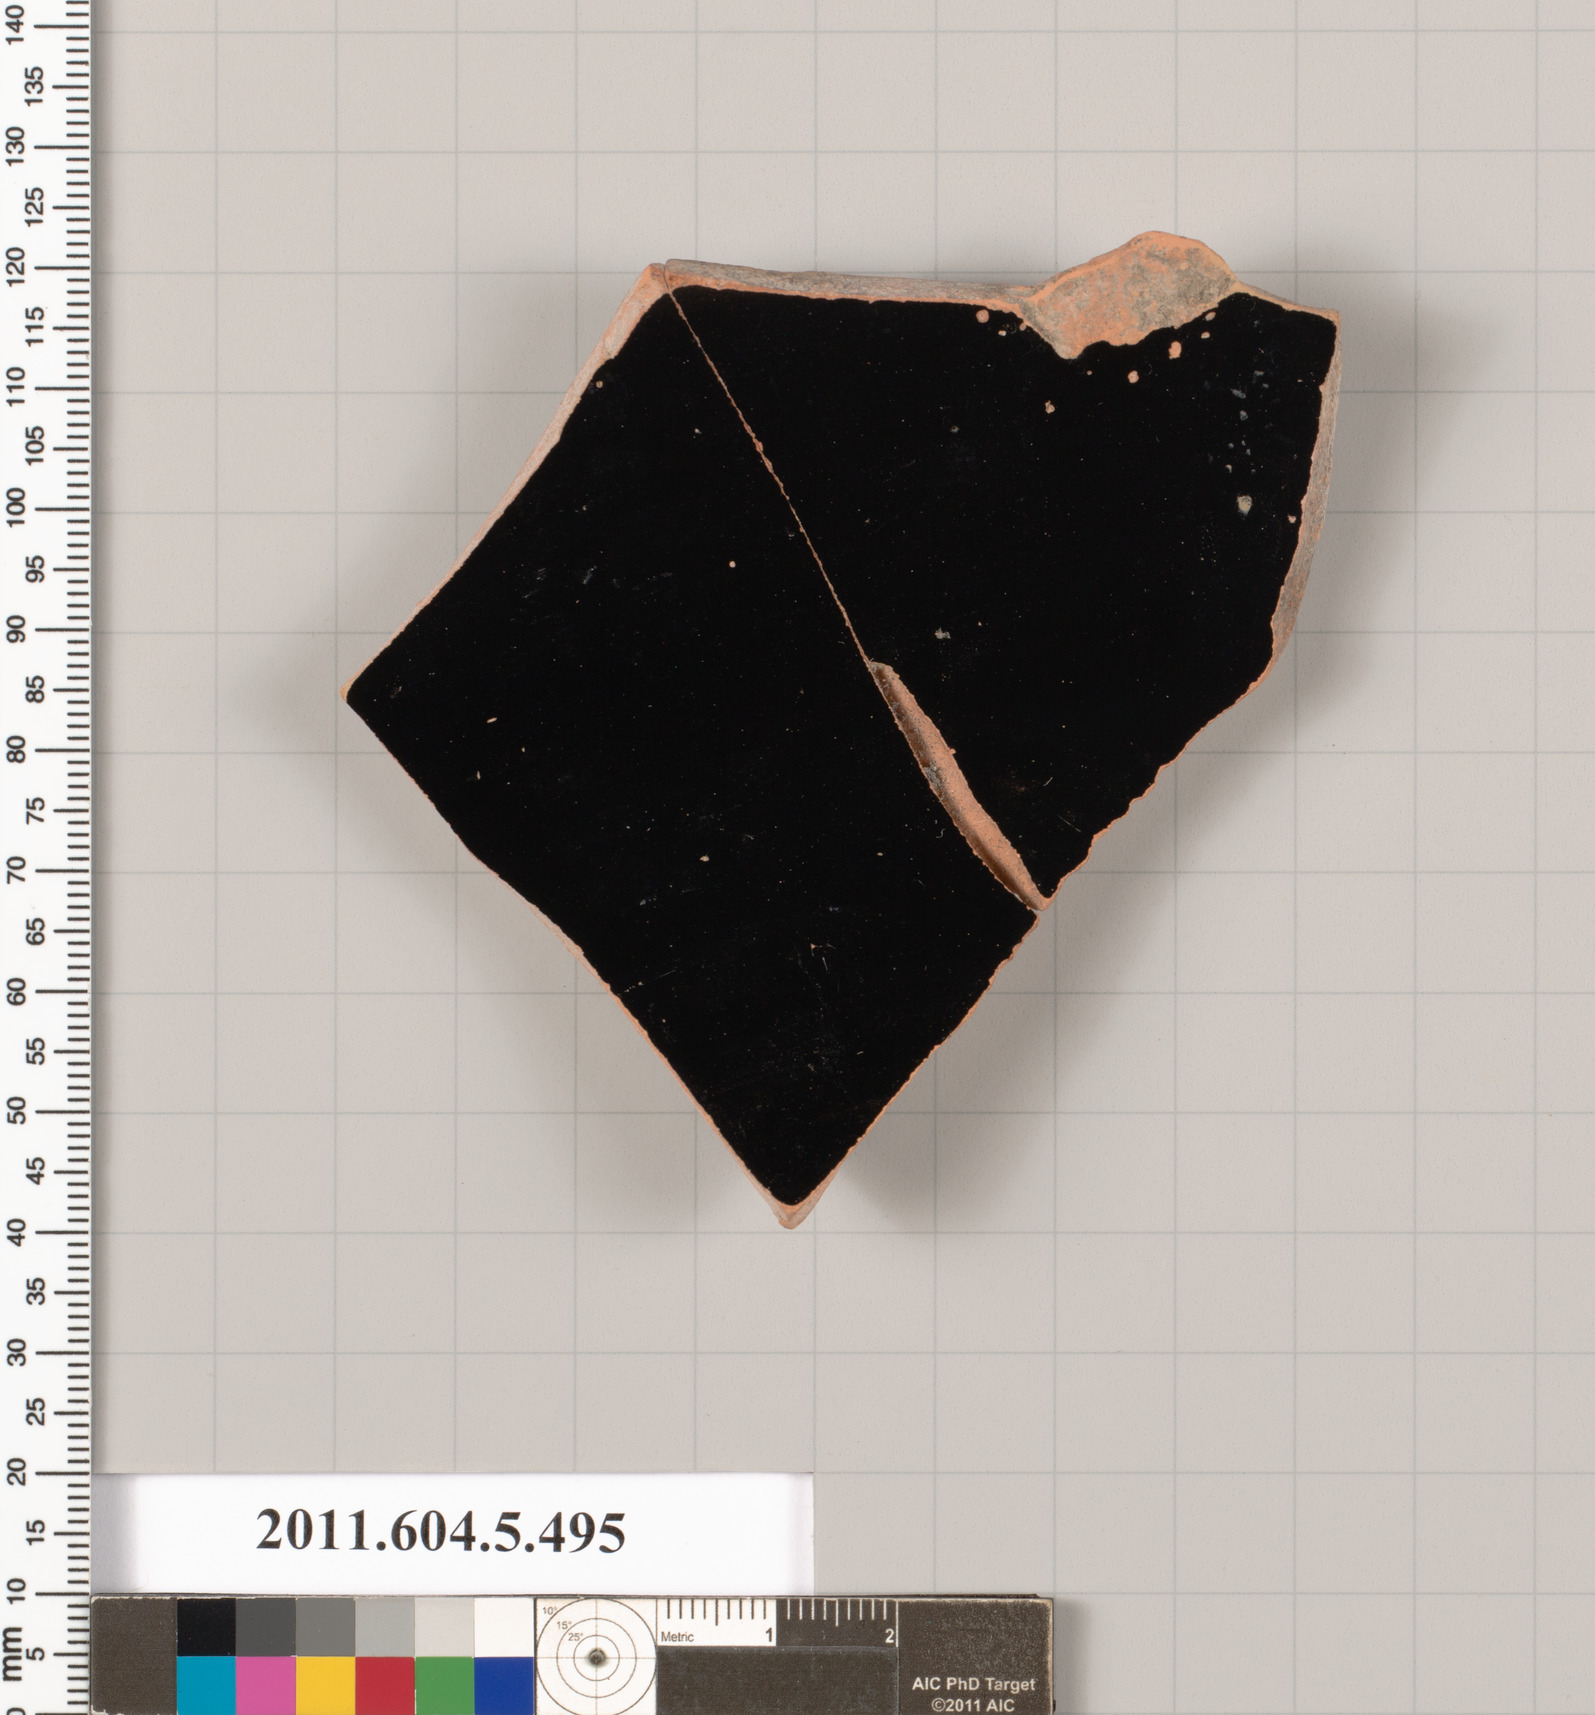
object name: kylix fragment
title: Terracotta fragment of a kylix (drinking cup)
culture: greek, attic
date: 600-401 BCE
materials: terracotta